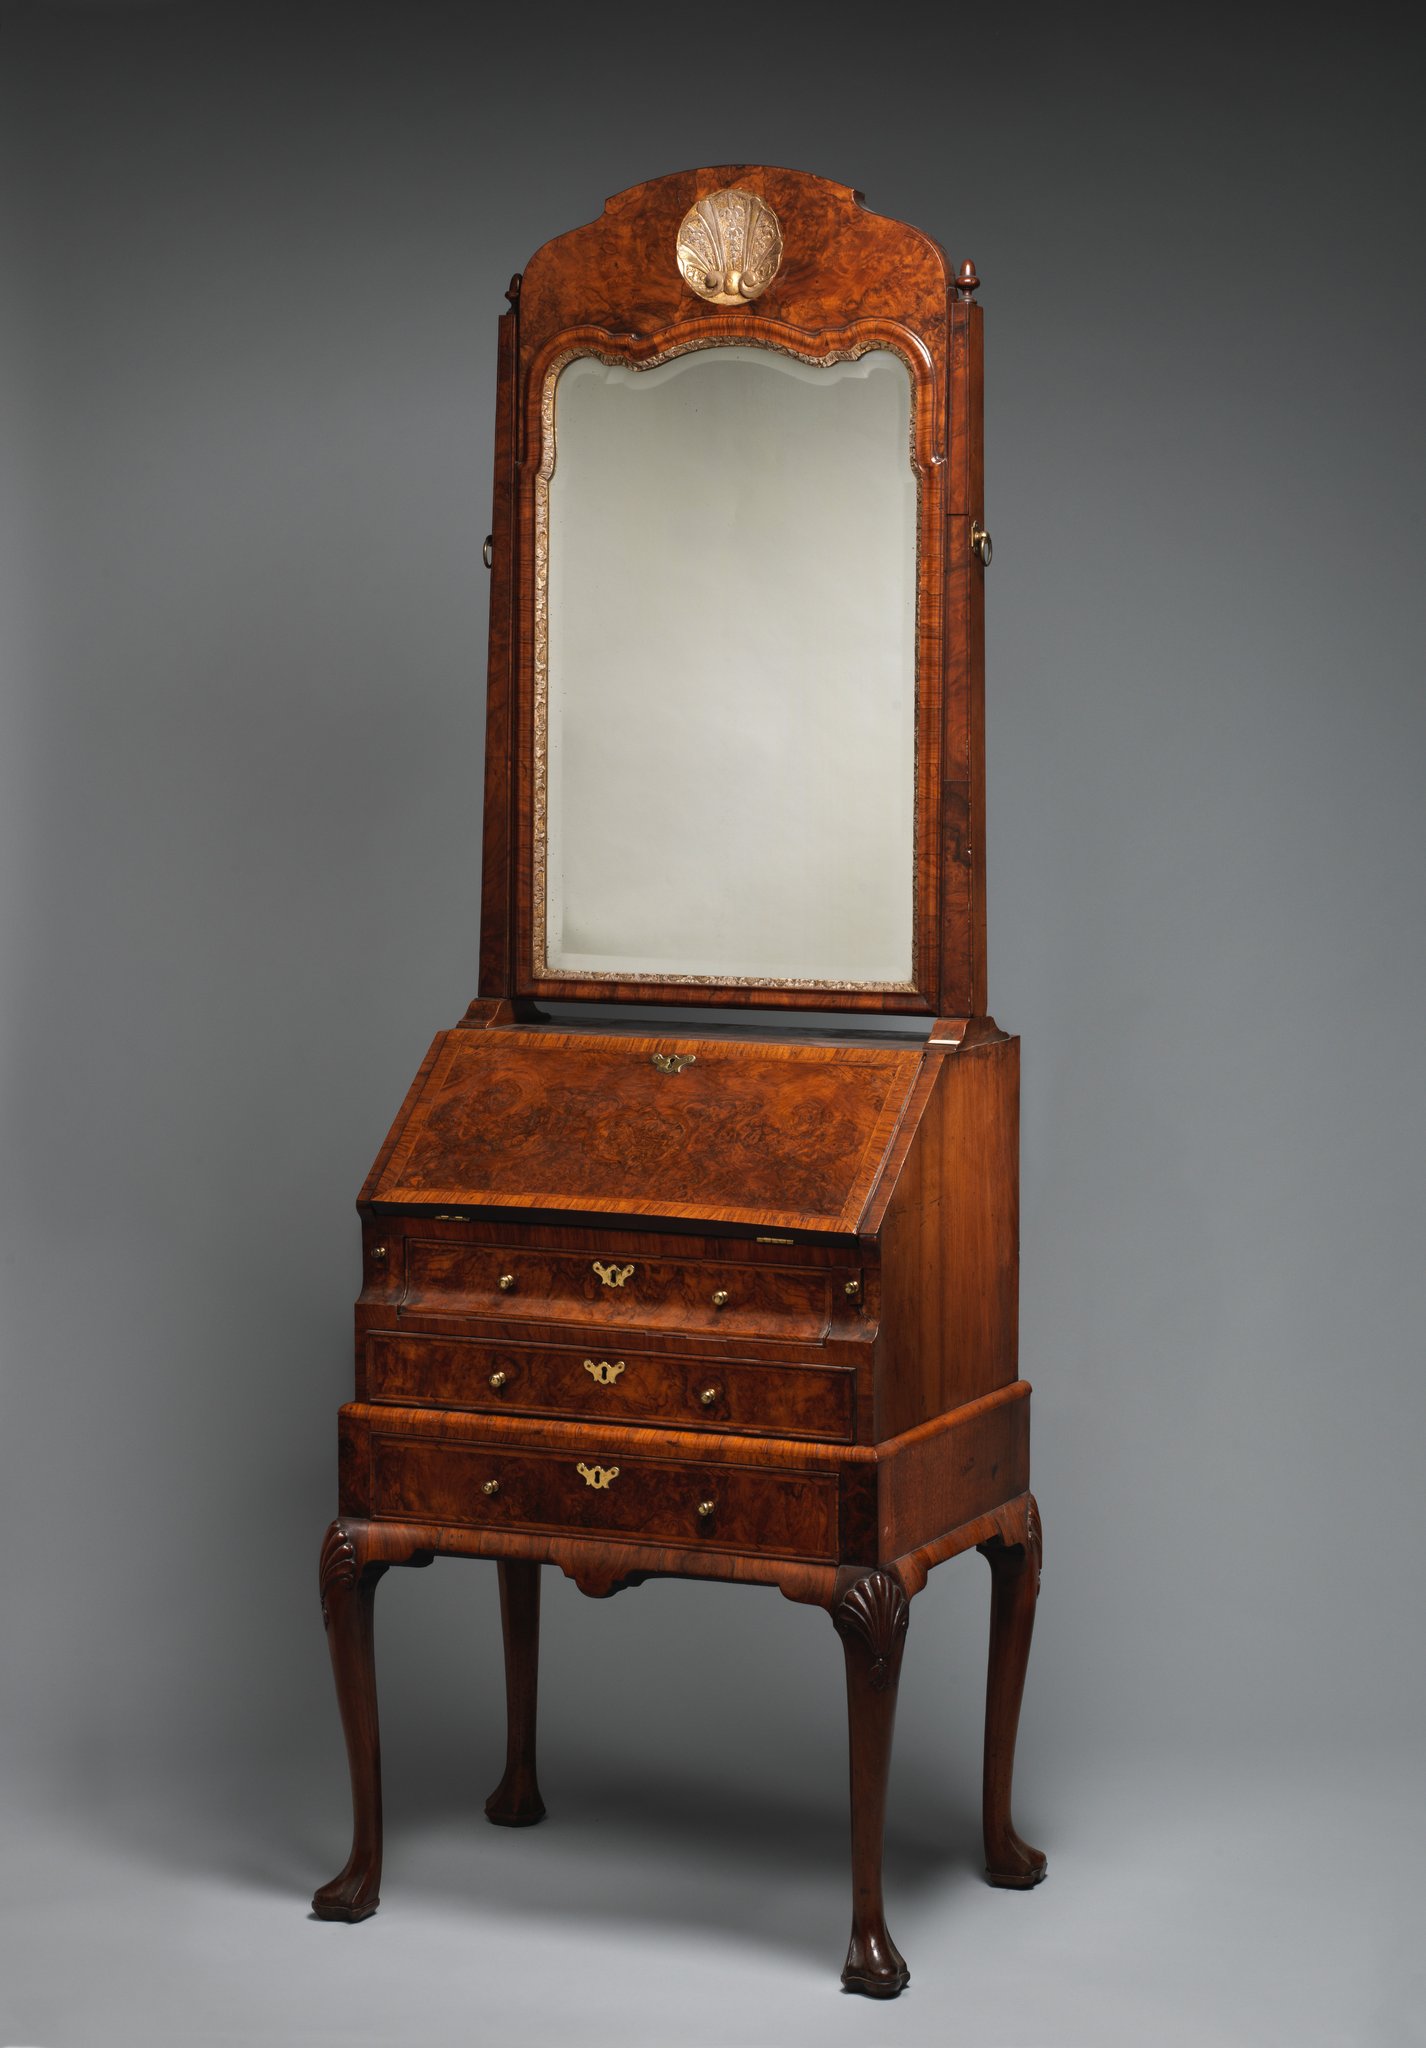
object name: bureau dressing table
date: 1725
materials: gilt, glass, wood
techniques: veneering